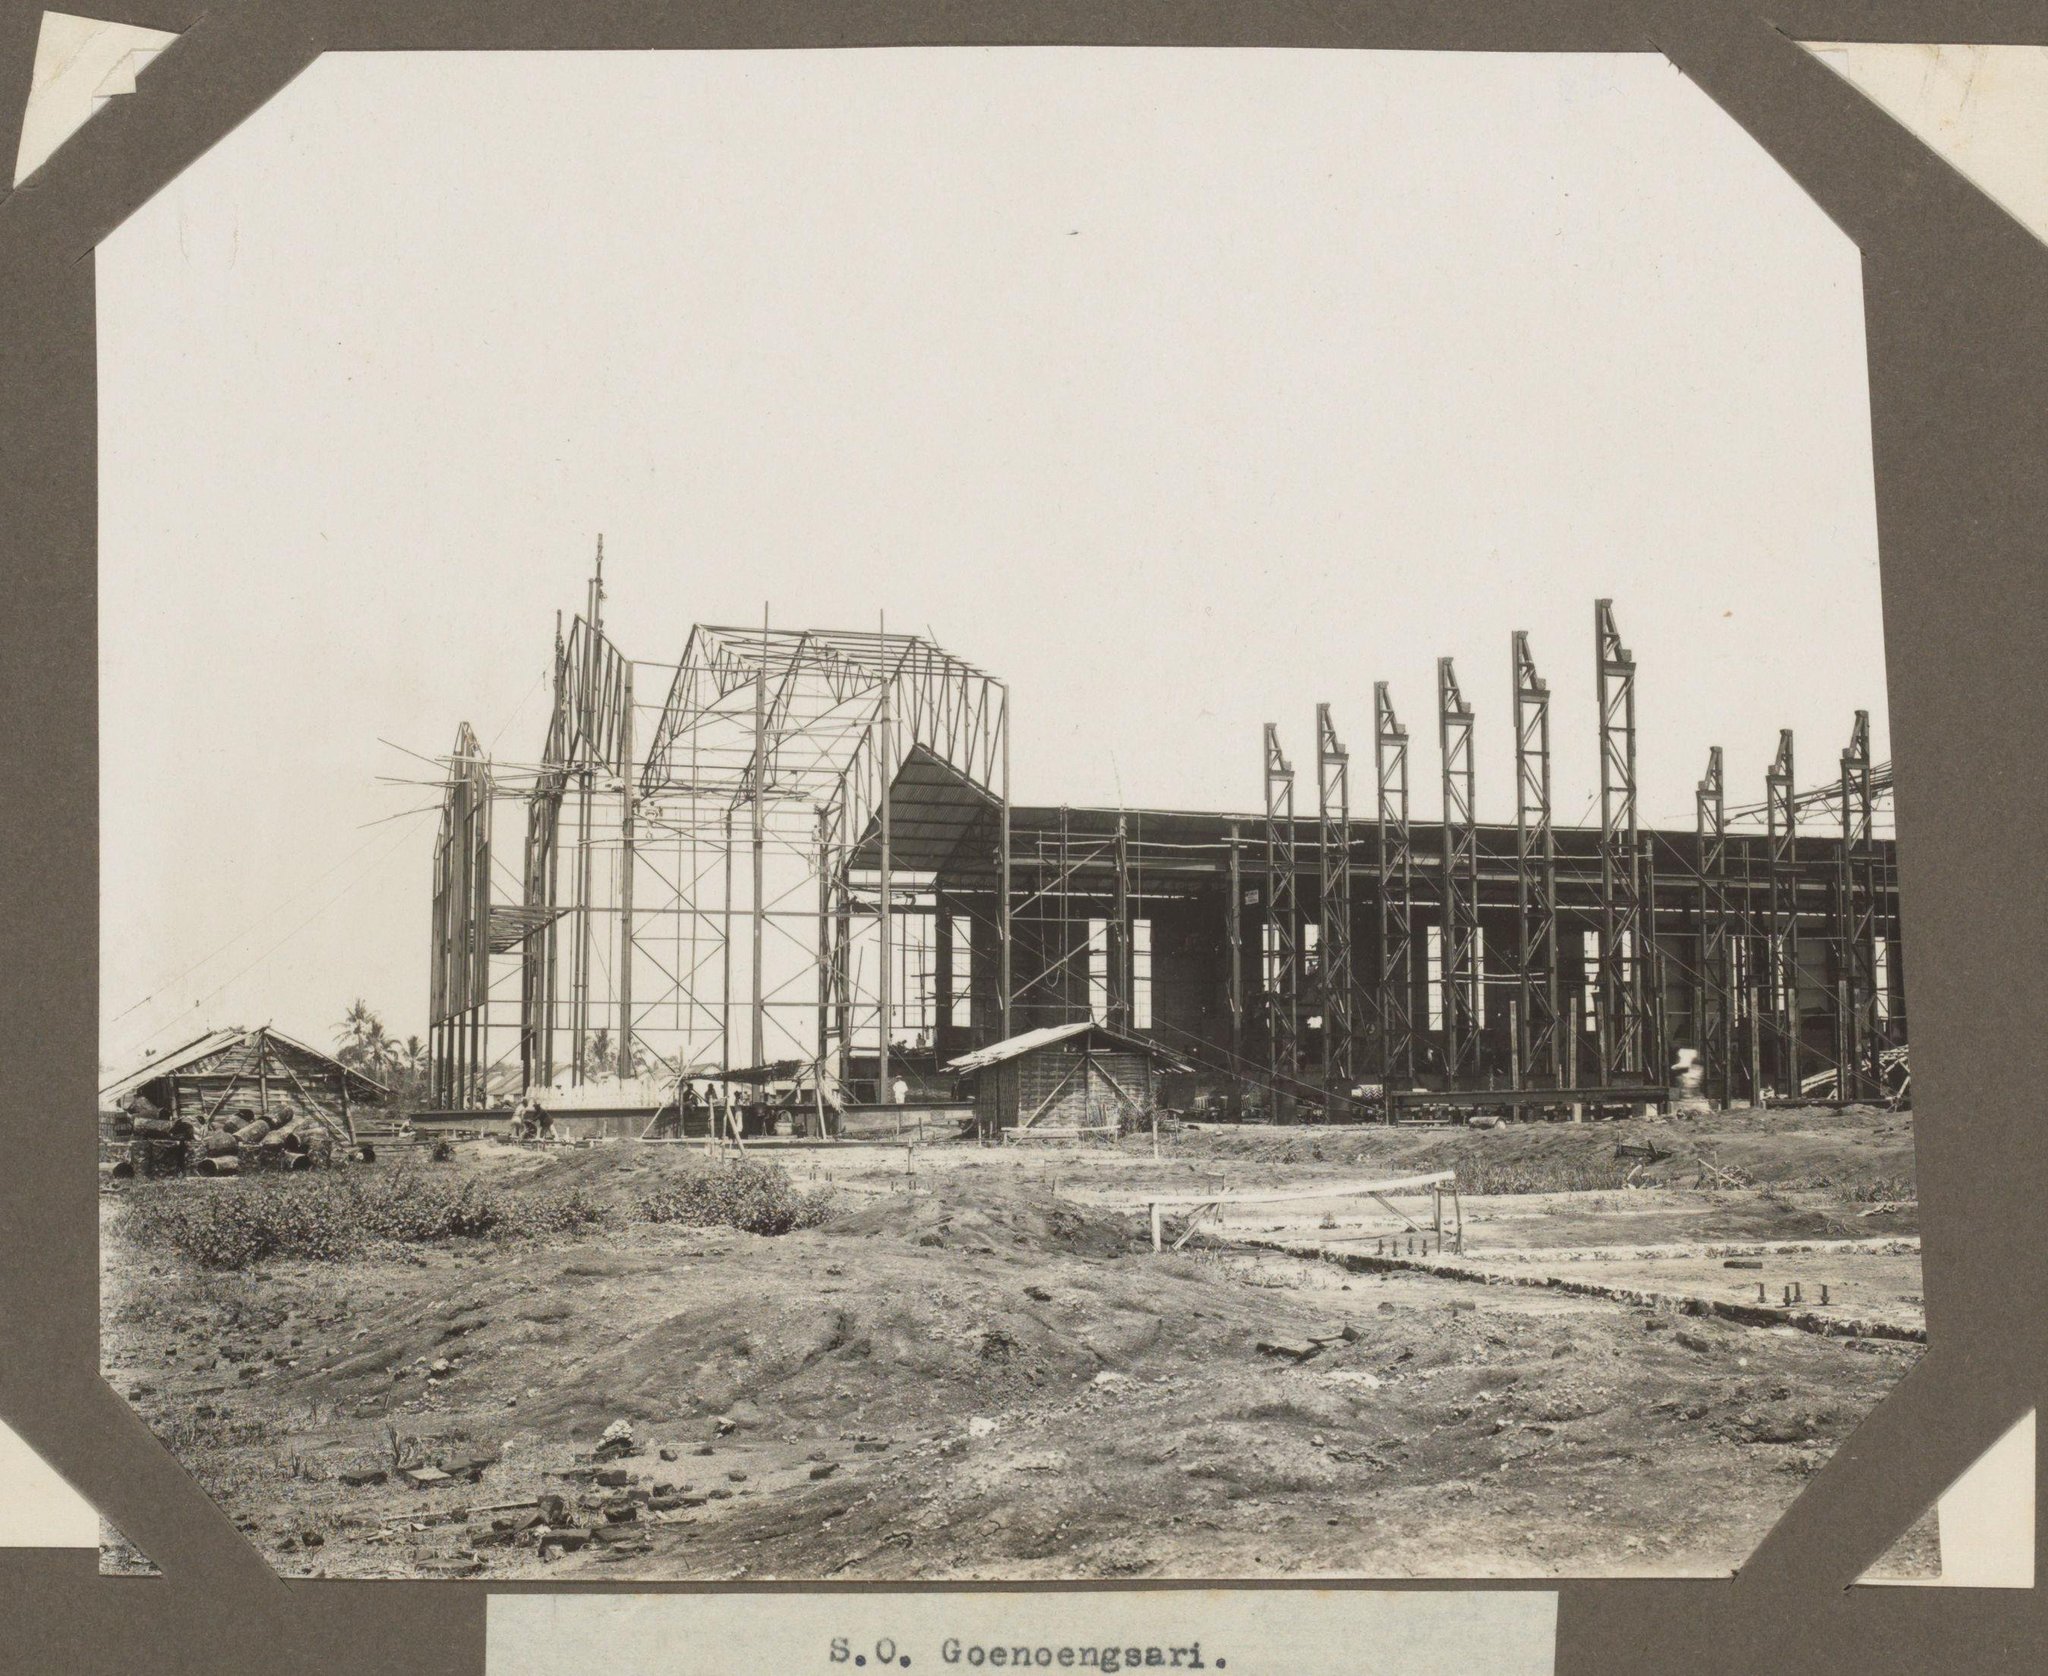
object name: photograph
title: S.O. Goenoengsari. Molenstation gezien vanaf de Oost. 3 December 1926.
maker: Anonymous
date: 1912-1926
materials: photographic support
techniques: gelatin silver print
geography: east java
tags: colonial system, trade-company, making the overground structures (~ building activities), industrial structures, (non-fruit) products of plants or trees: sugarcane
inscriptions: inscription: ‘S.O. Goenoengsari. Molenstation gezien vanaf de Oost. 3 December 1926.’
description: Het molenstation in aanbouw, 3 december 1926. Onderdeel van het fotoalbum met foto's van de opbouw van de suikerfabriek te Goenoengsari op Oost-Java door de Handels Vereniging Amsterdam 1926-1927.